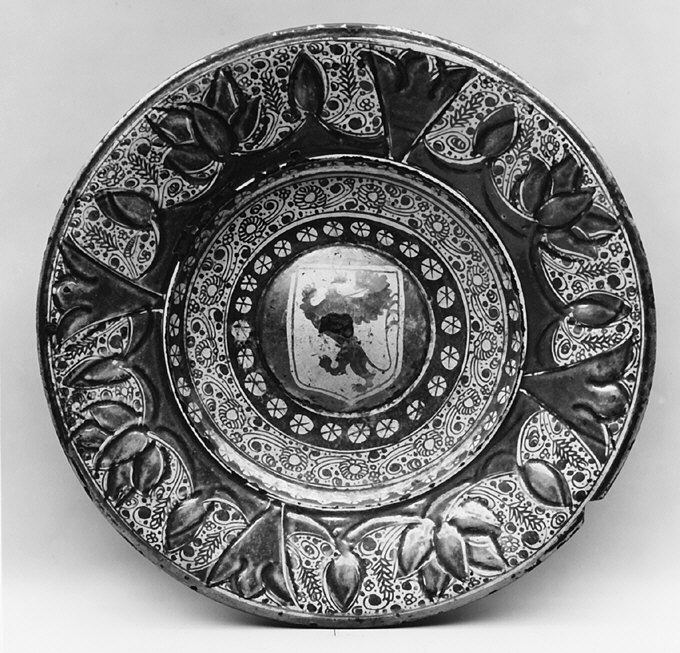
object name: dish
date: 1501-1550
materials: earthenware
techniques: luster painting, glazing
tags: flowers,insignia